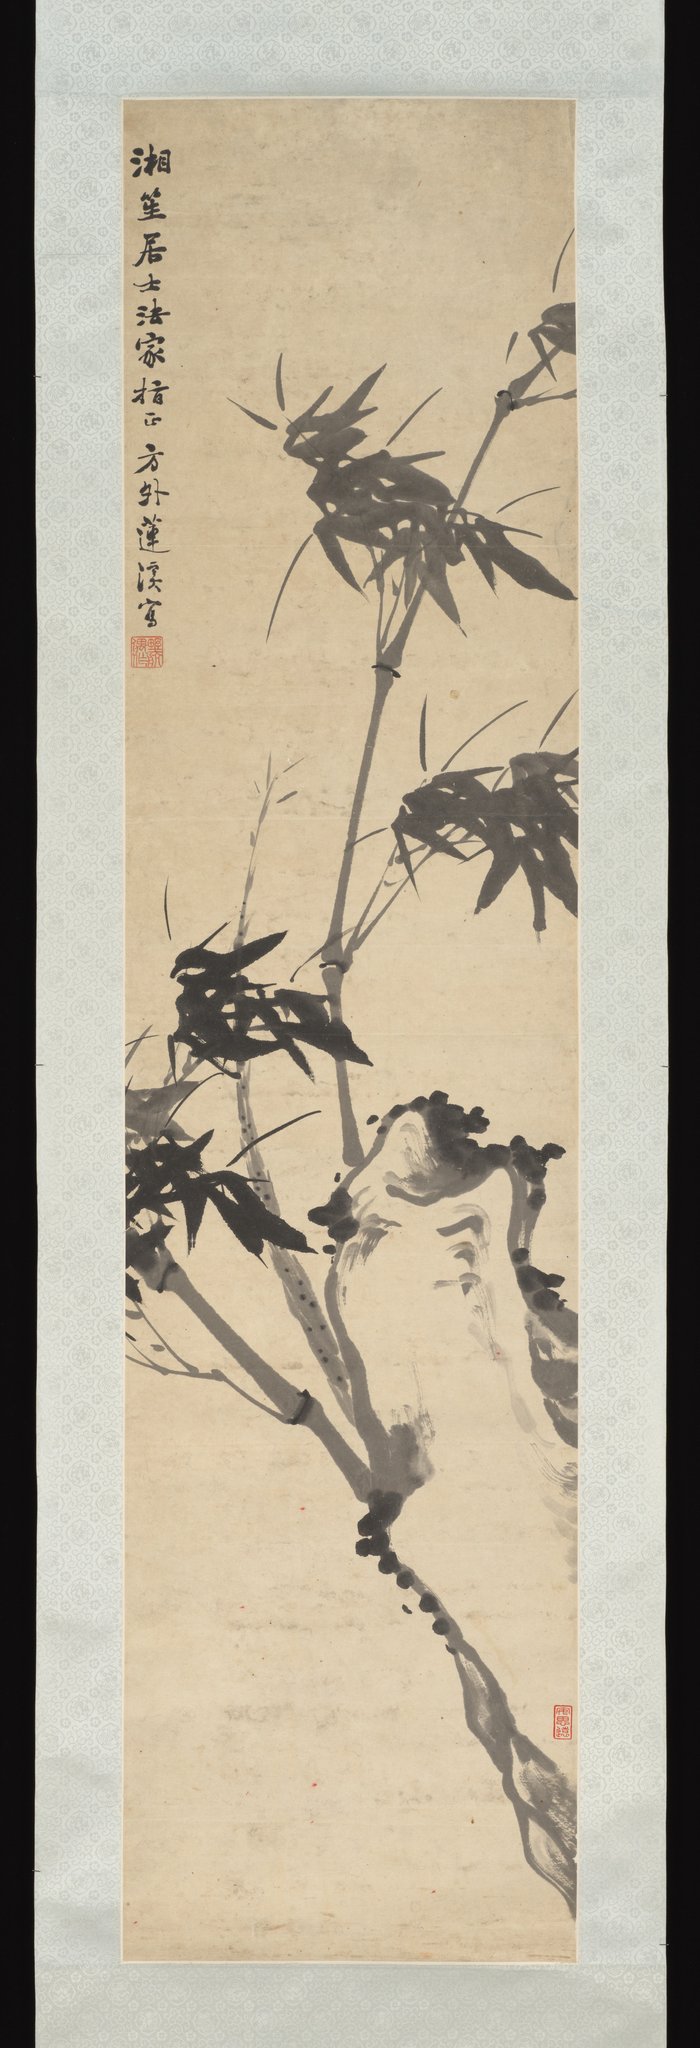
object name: hanging scroll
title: Bamboo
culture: chinese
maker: chen ran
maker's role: artist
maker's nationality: chinese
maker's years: 1816-1884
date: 1816-1884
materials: ink, paper